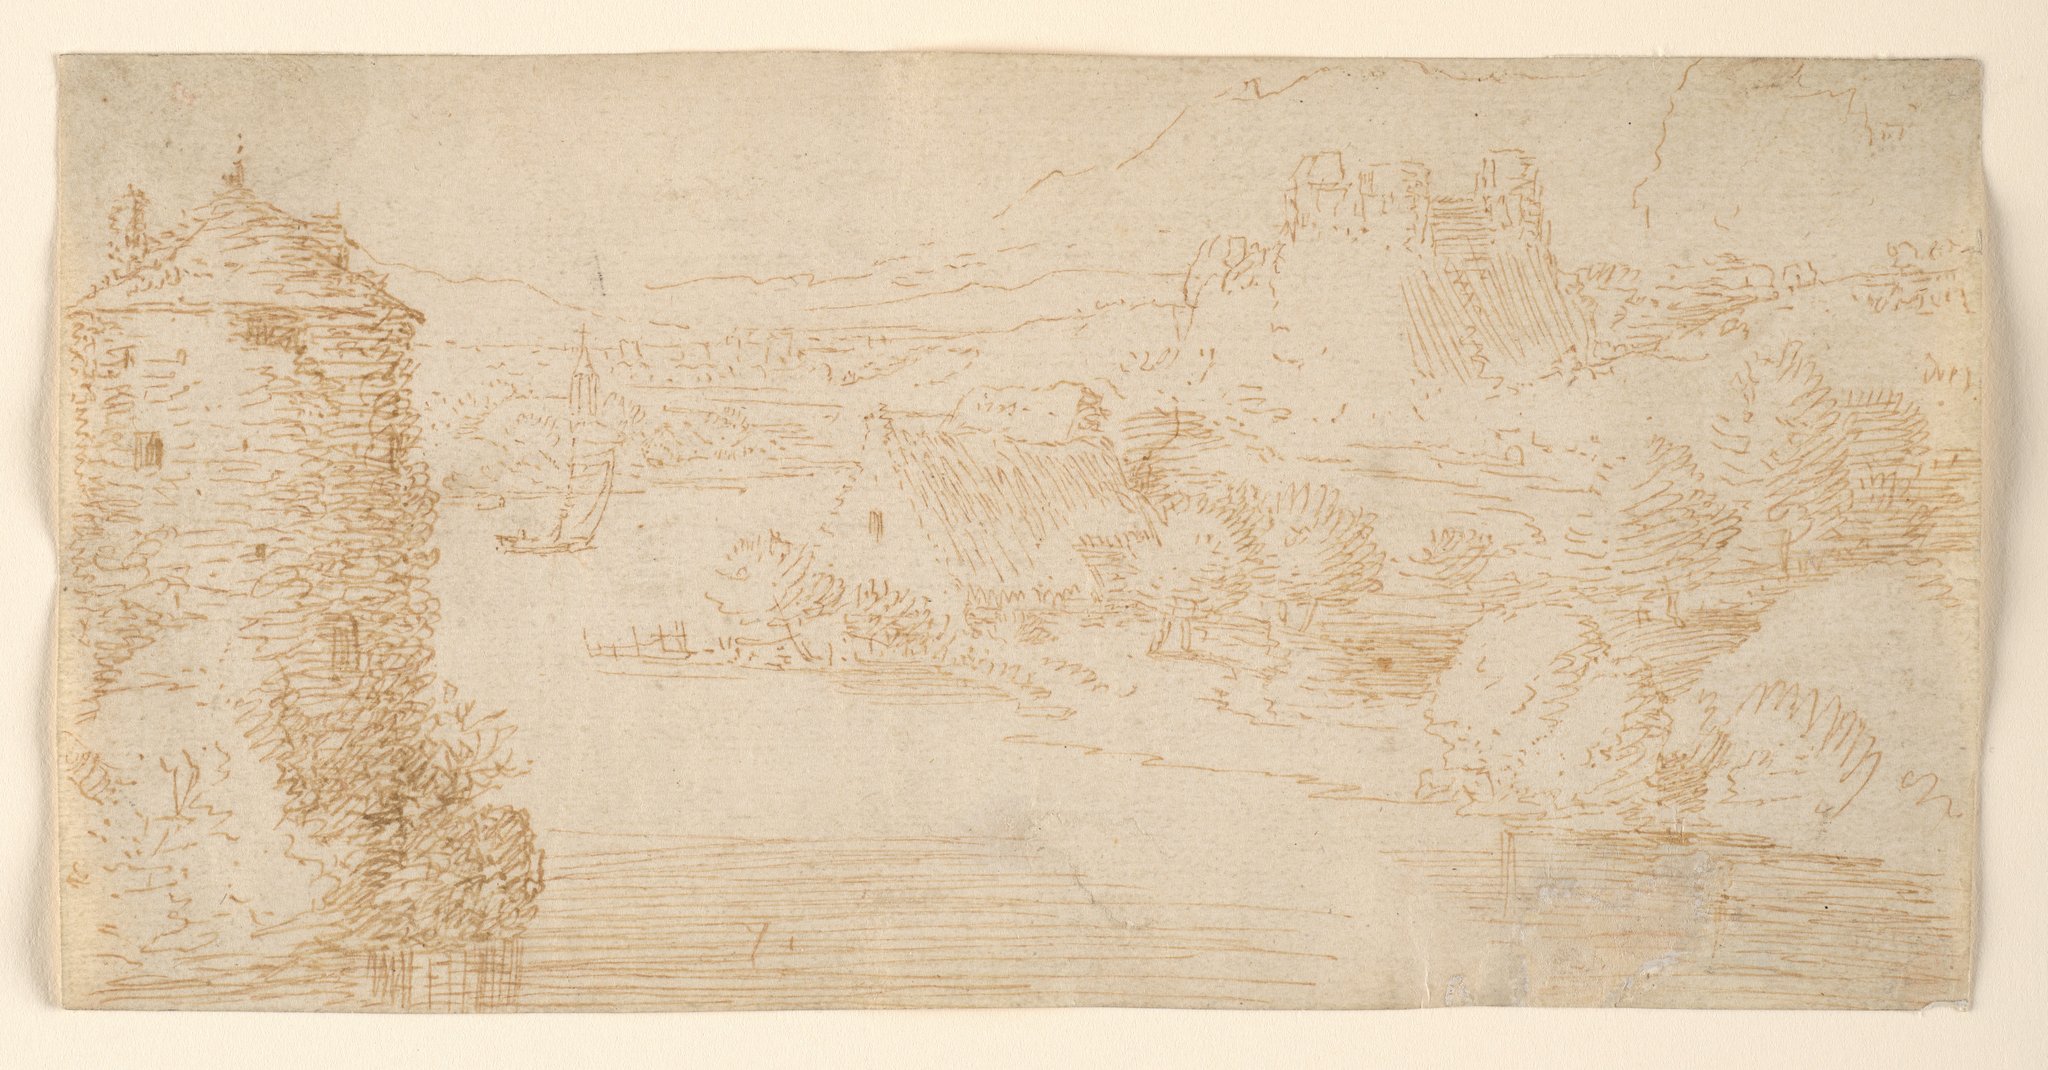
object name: drawing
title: River Landscape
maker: jaques saverij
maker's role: artist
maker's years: 1565-1603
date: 1600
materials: ink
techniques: pen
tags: rivers,landscapes